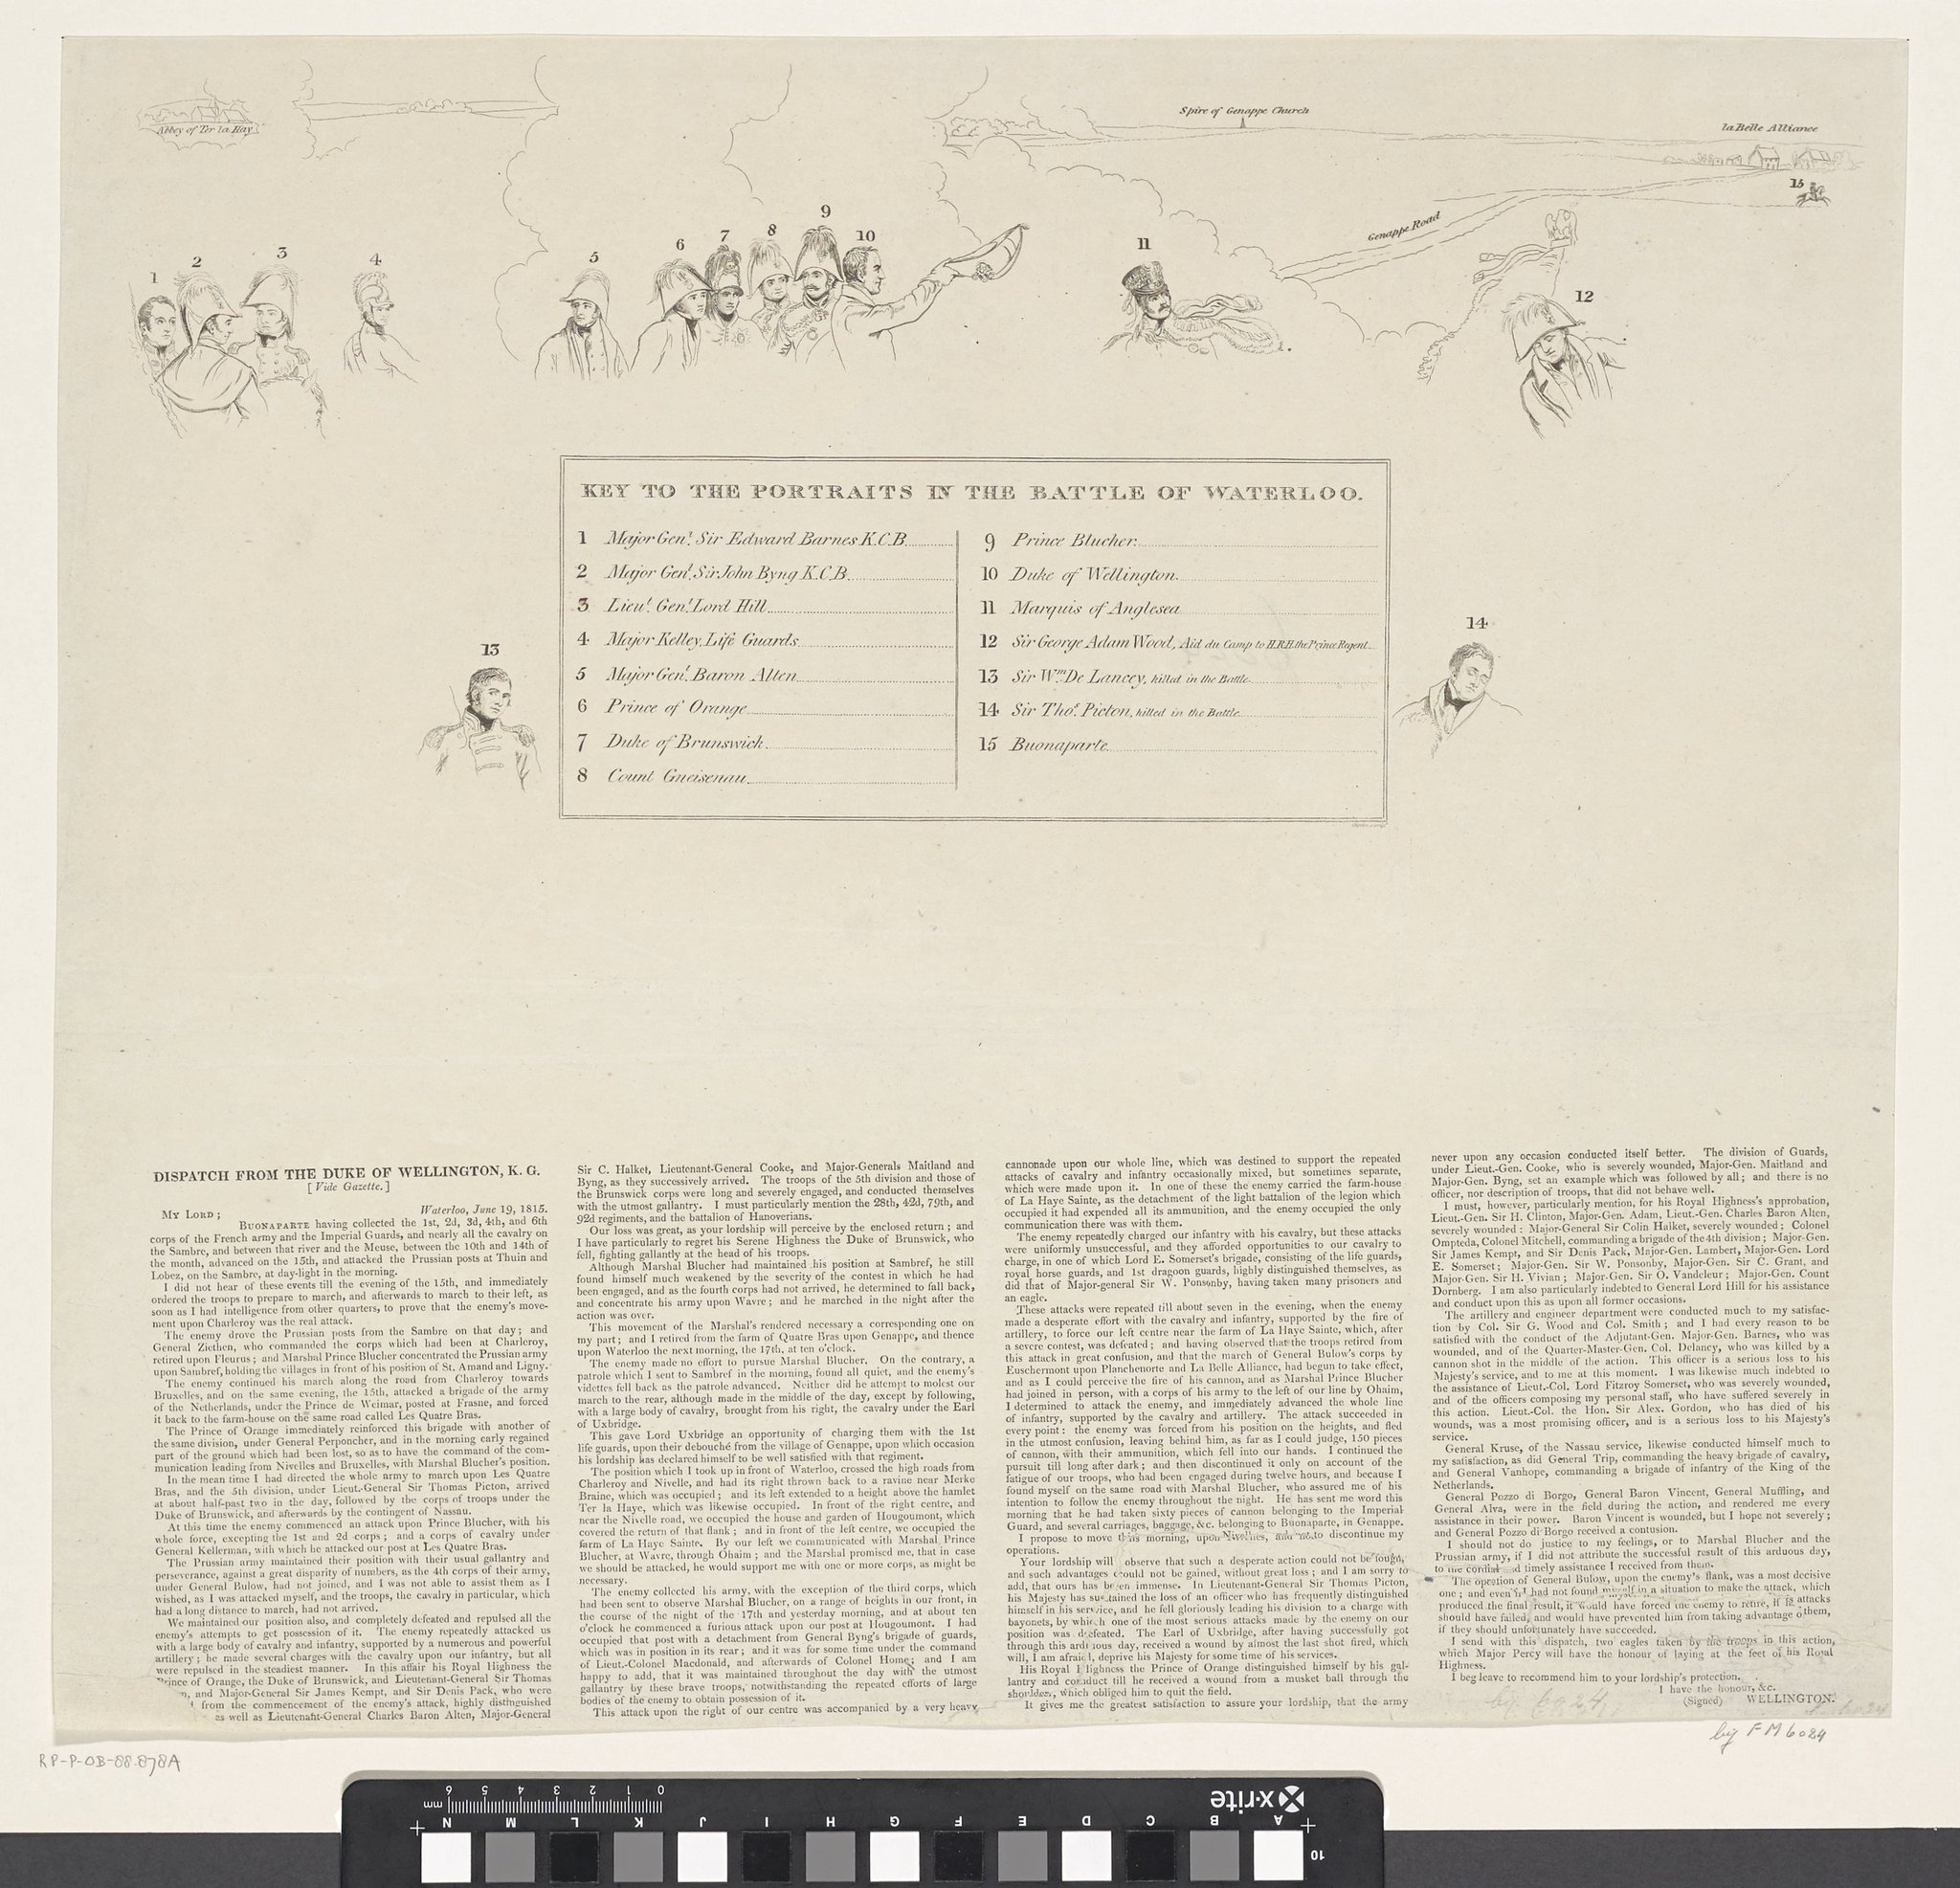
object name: history print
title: Sleutel bij de prent van de Slag bij Waterloo, 1815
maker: john burnet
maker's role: print maker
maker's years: 1784-1868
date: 1819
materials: paper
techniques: etching, letterpress printing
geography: england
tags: william ii of the netherlands, walmer castle, arthur wellesley of wellington, battle (+ land forces), waterloo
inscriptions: collector's mark: Lugt 2228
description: Sleutel behorende bij de prent van de hertog van Wellington tijdens de slag bij Waterloo, 18 juni 1815. Met de legenda voor de portretten van nrs. 1-15. Onder de plaat een gedrukt verslag van het gevecht door Wellington, tekst in het Engels in vier kolommen.